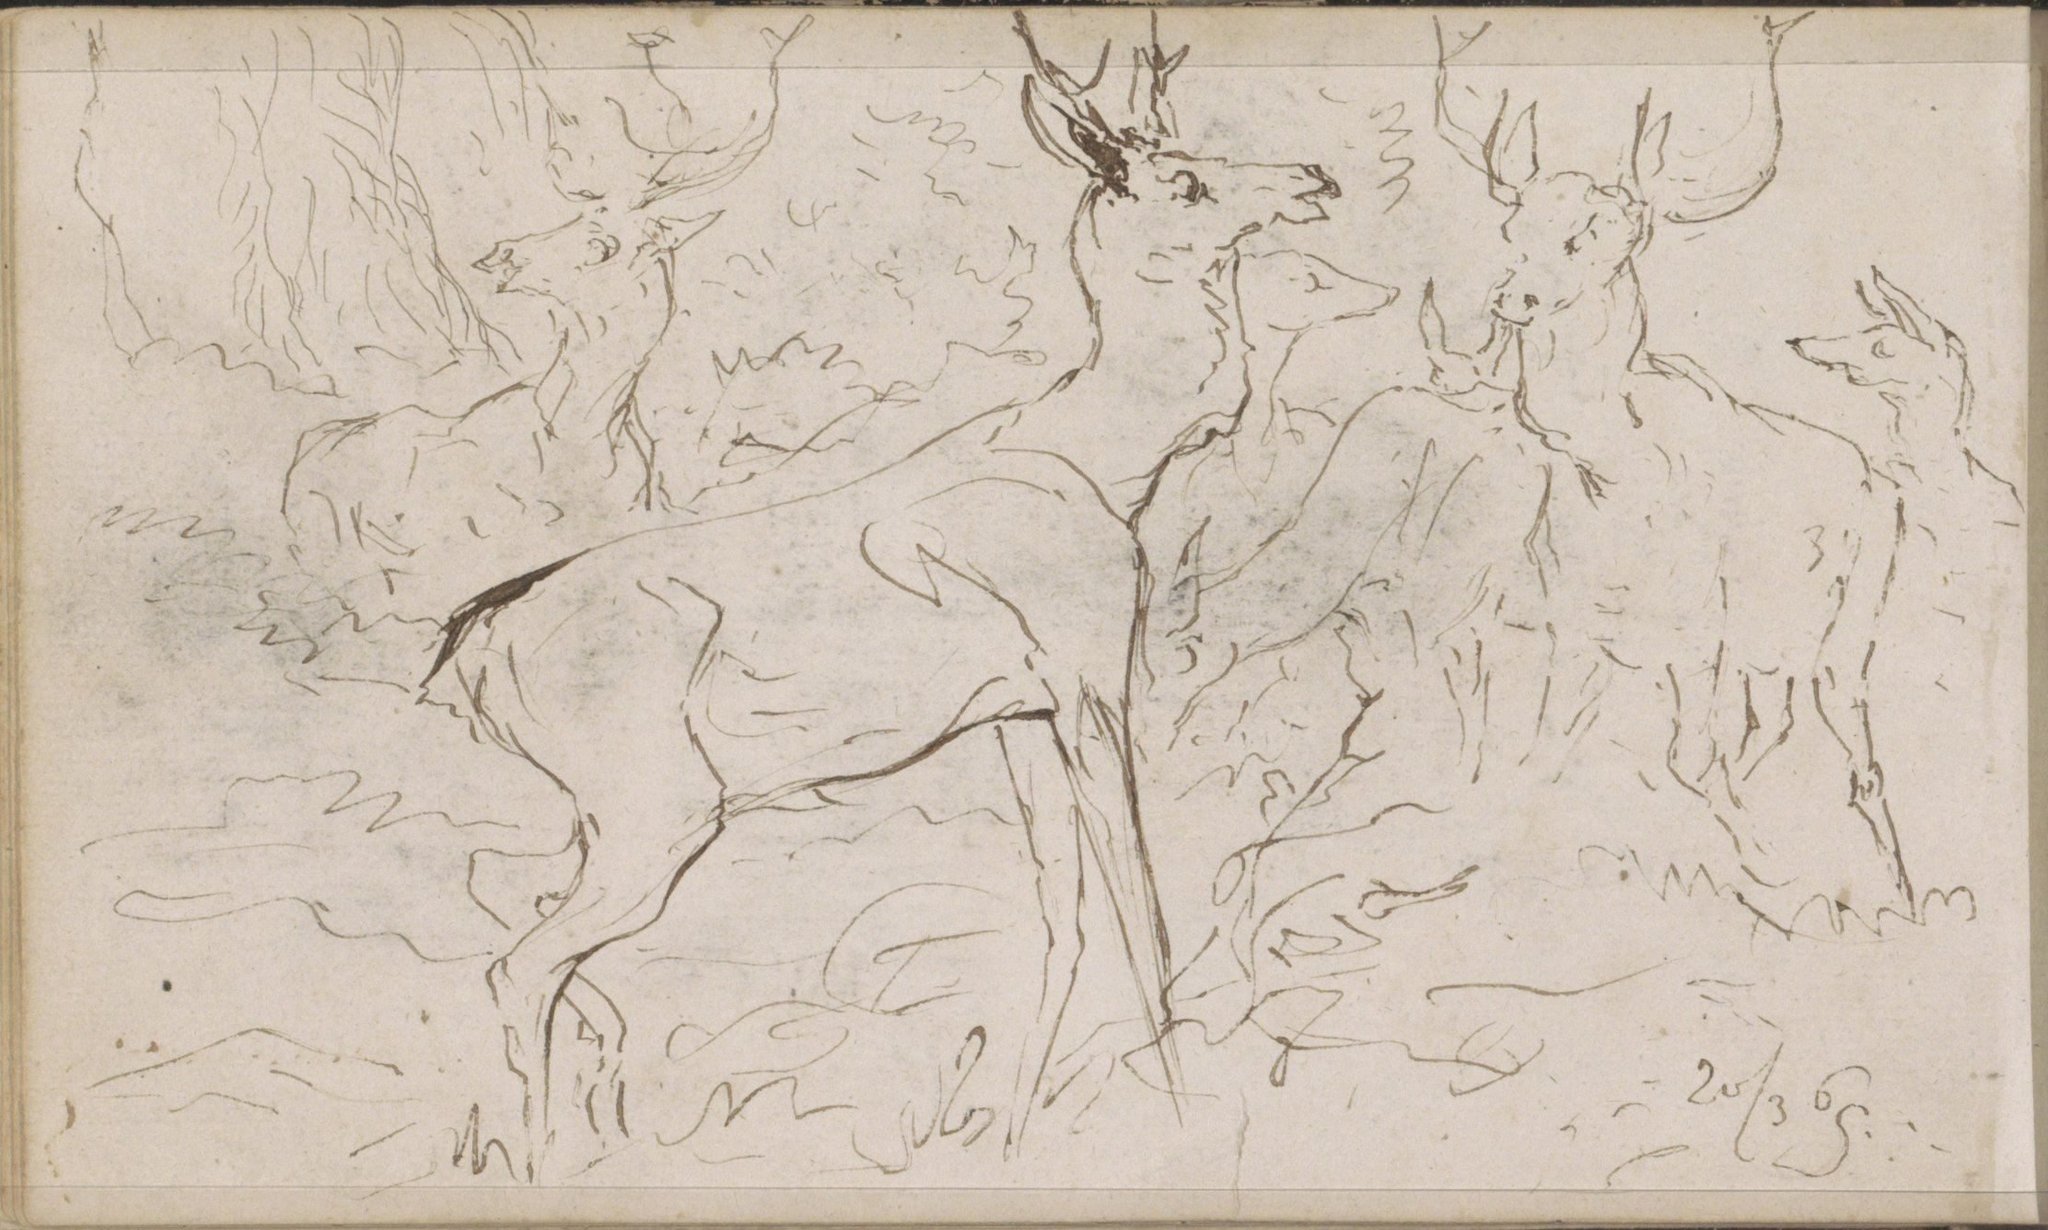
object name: sketchbook leaf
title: Herten in een bosachtige omgeving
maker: johannes tavenraat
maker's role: draughtsman, painter, print maker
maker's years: 1809-1881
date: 1803-1865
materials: ink, paper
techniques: pen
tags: trees, hoofed animals: deer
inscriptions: date: ‘20/3 65.’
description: Blad 21 verso uit een schetsboek met 98 bladen.